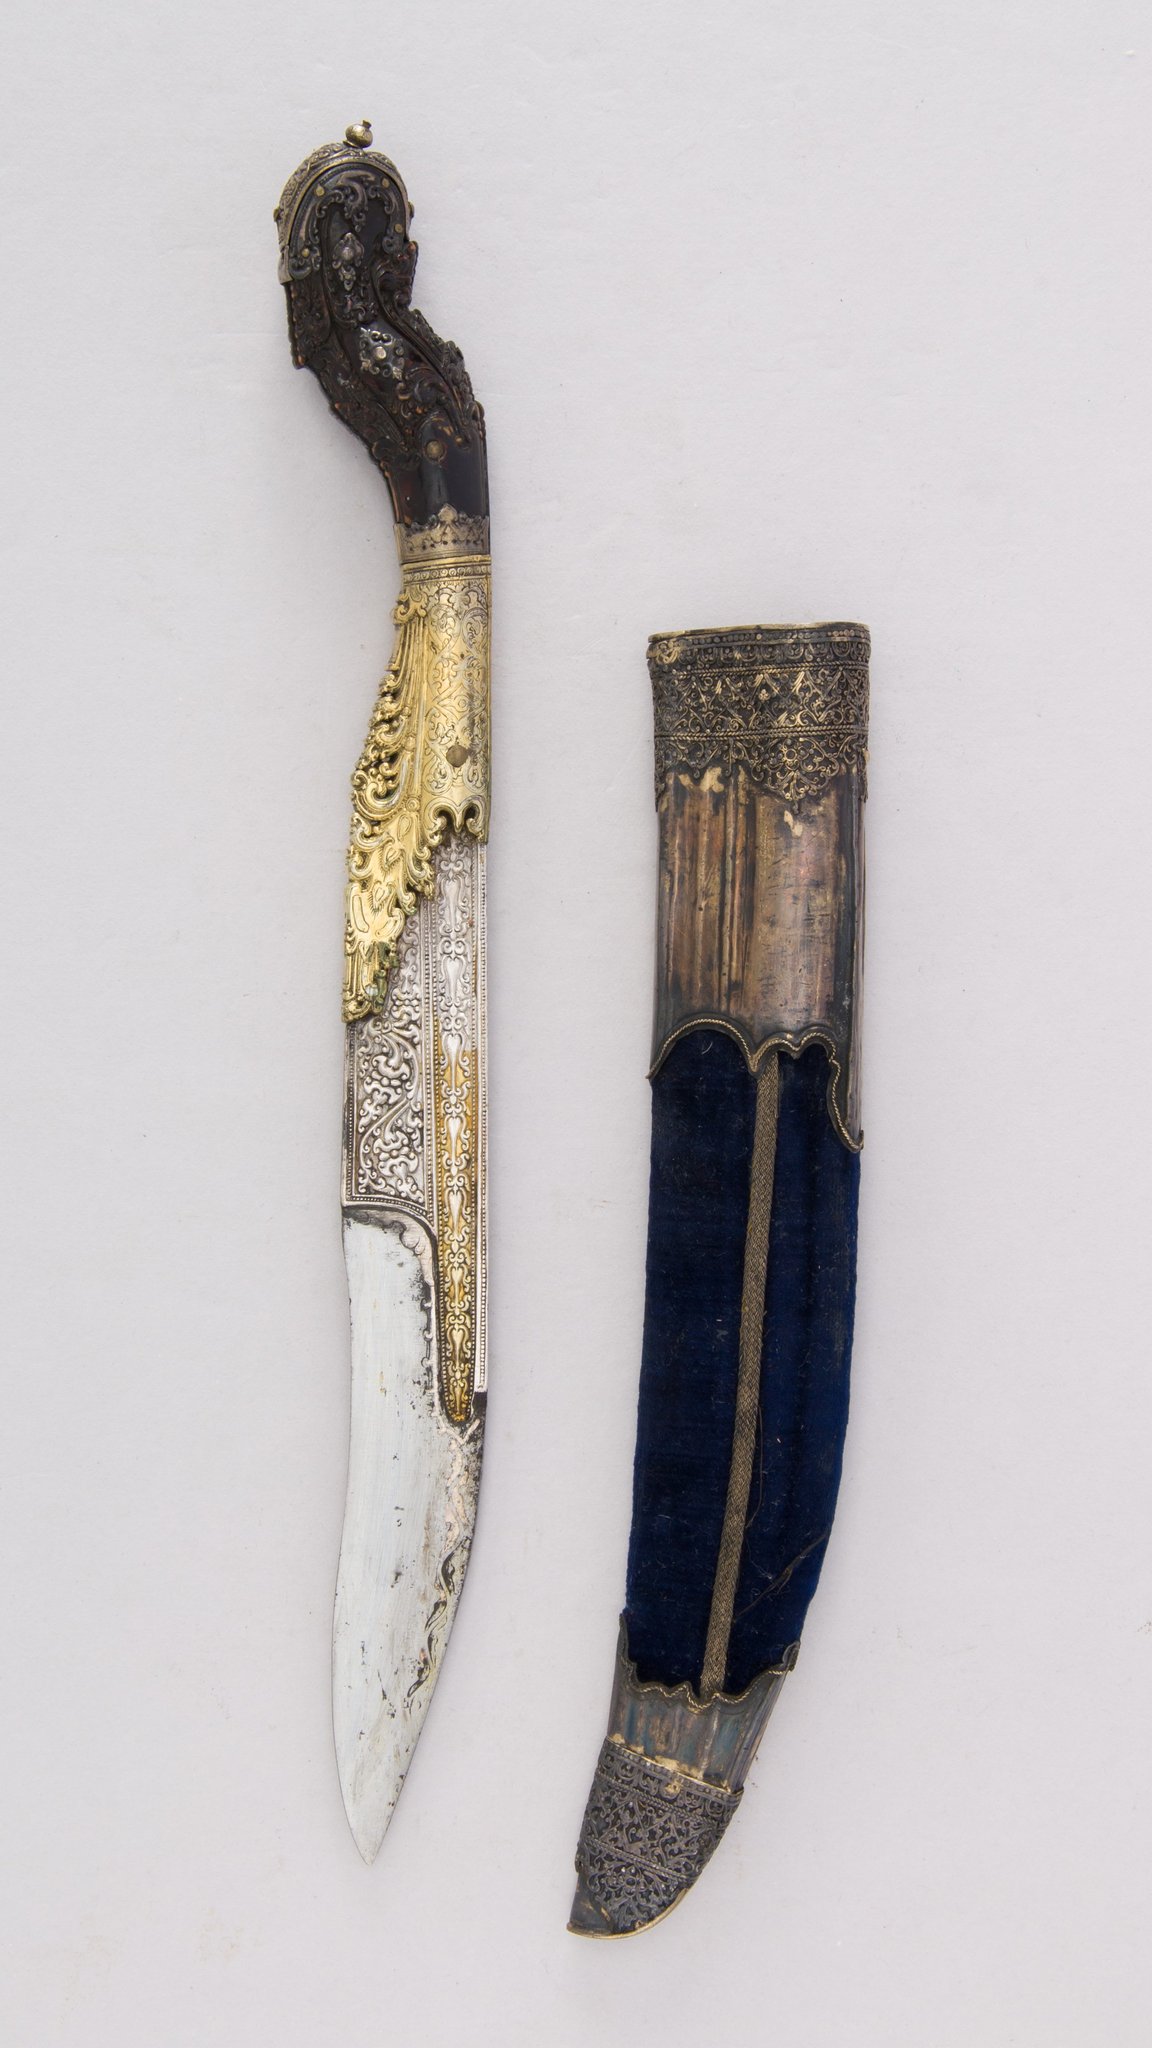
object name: knife piha kaetta with sheath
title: Knife (Piha Kaetta) with Sheath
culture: sri lankan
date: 1701-1900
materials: brass, silver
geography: sri lanka